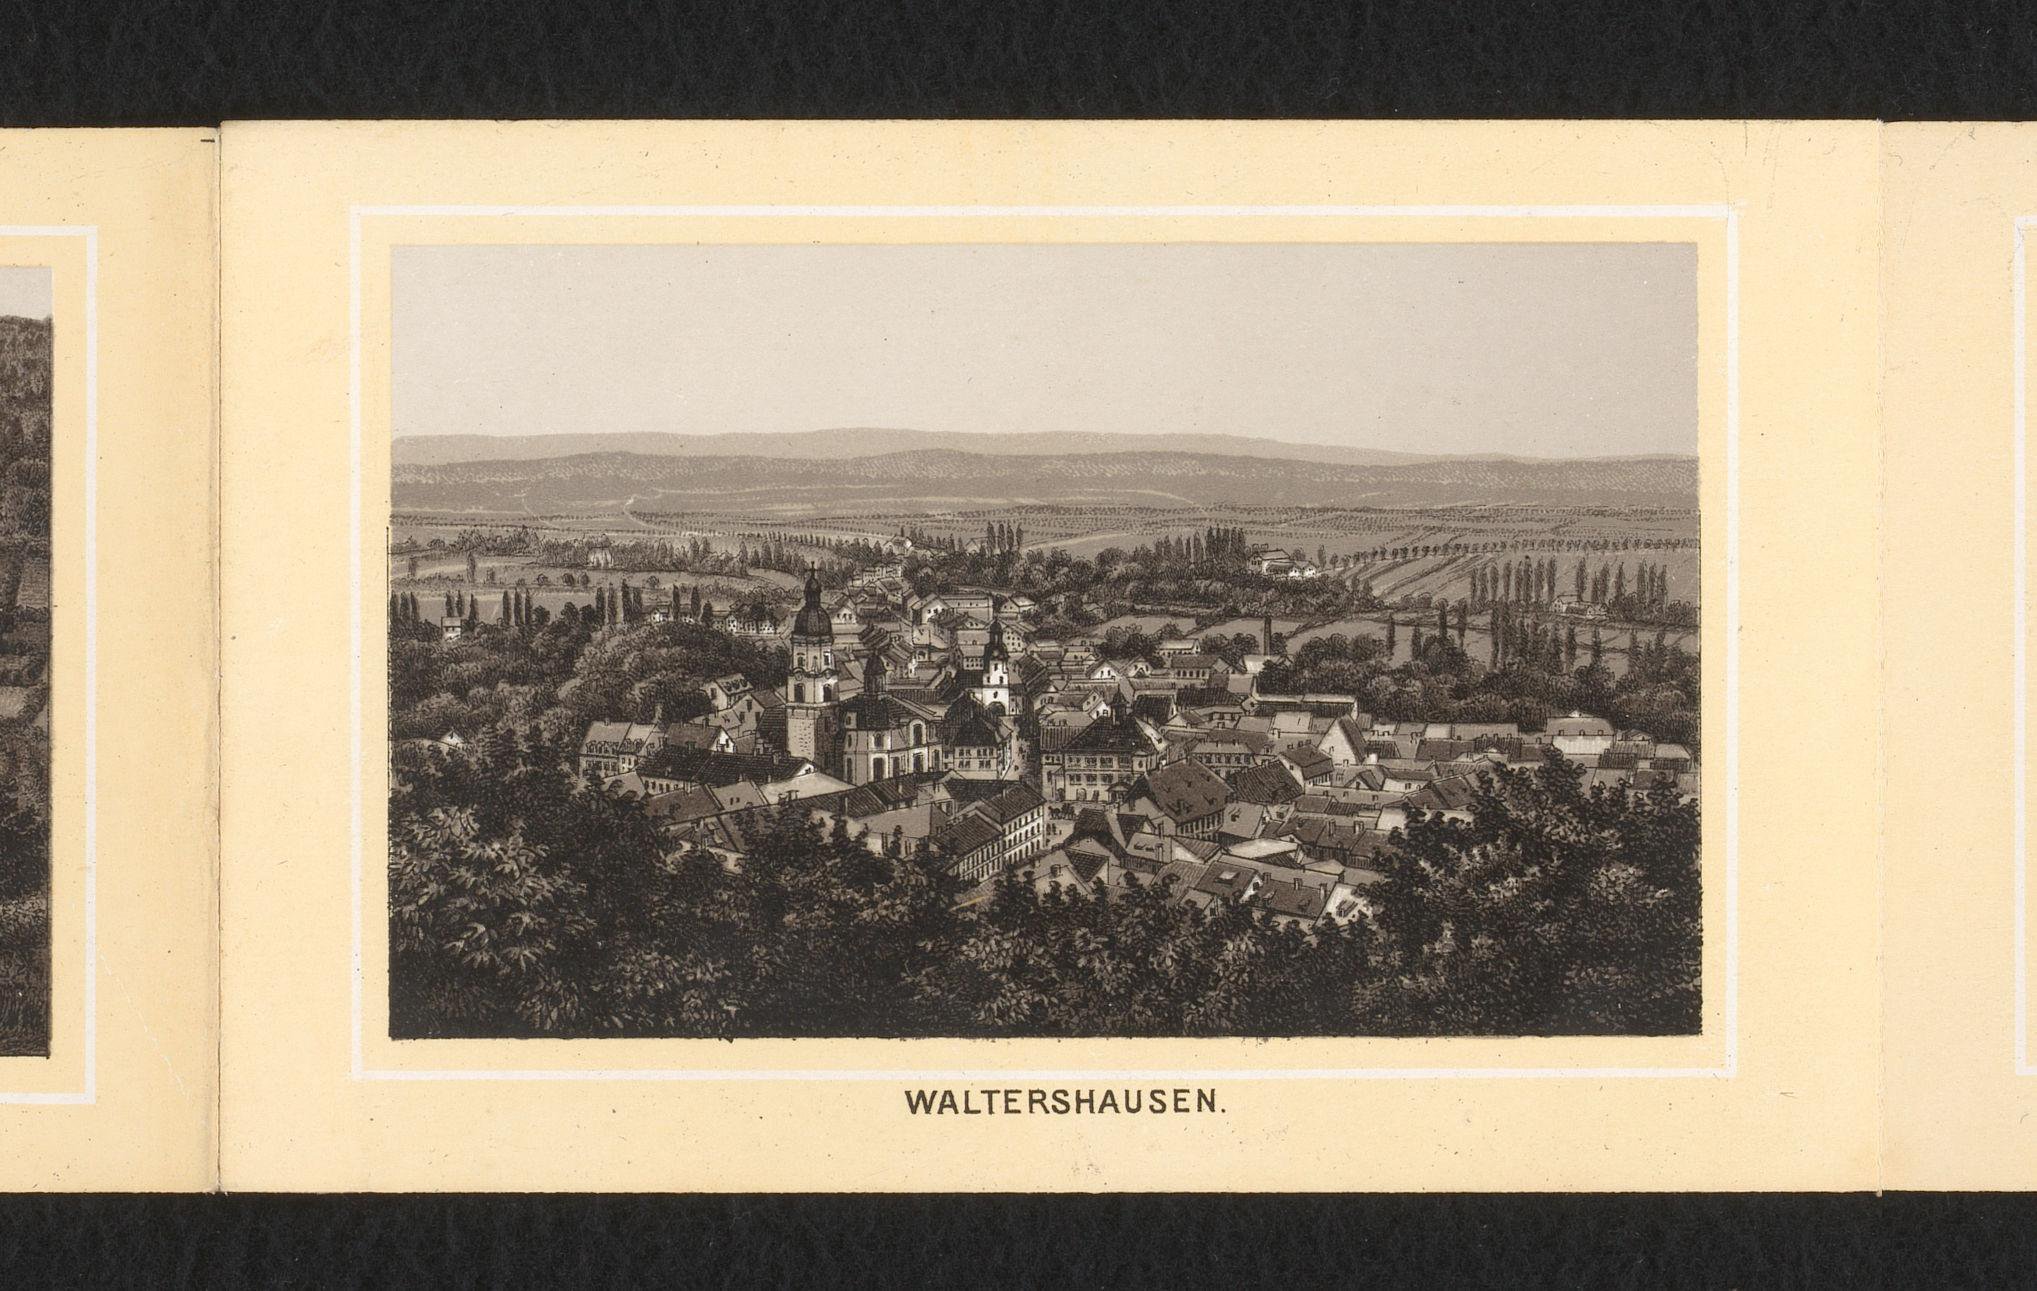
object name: photomechanical print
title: Waltershausen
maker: louis glaser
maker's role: printer, publisher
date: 1874-1900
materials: cardboard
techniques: photolithography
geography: leipzig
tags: city-view, and landscape with man-made constructions, mountains